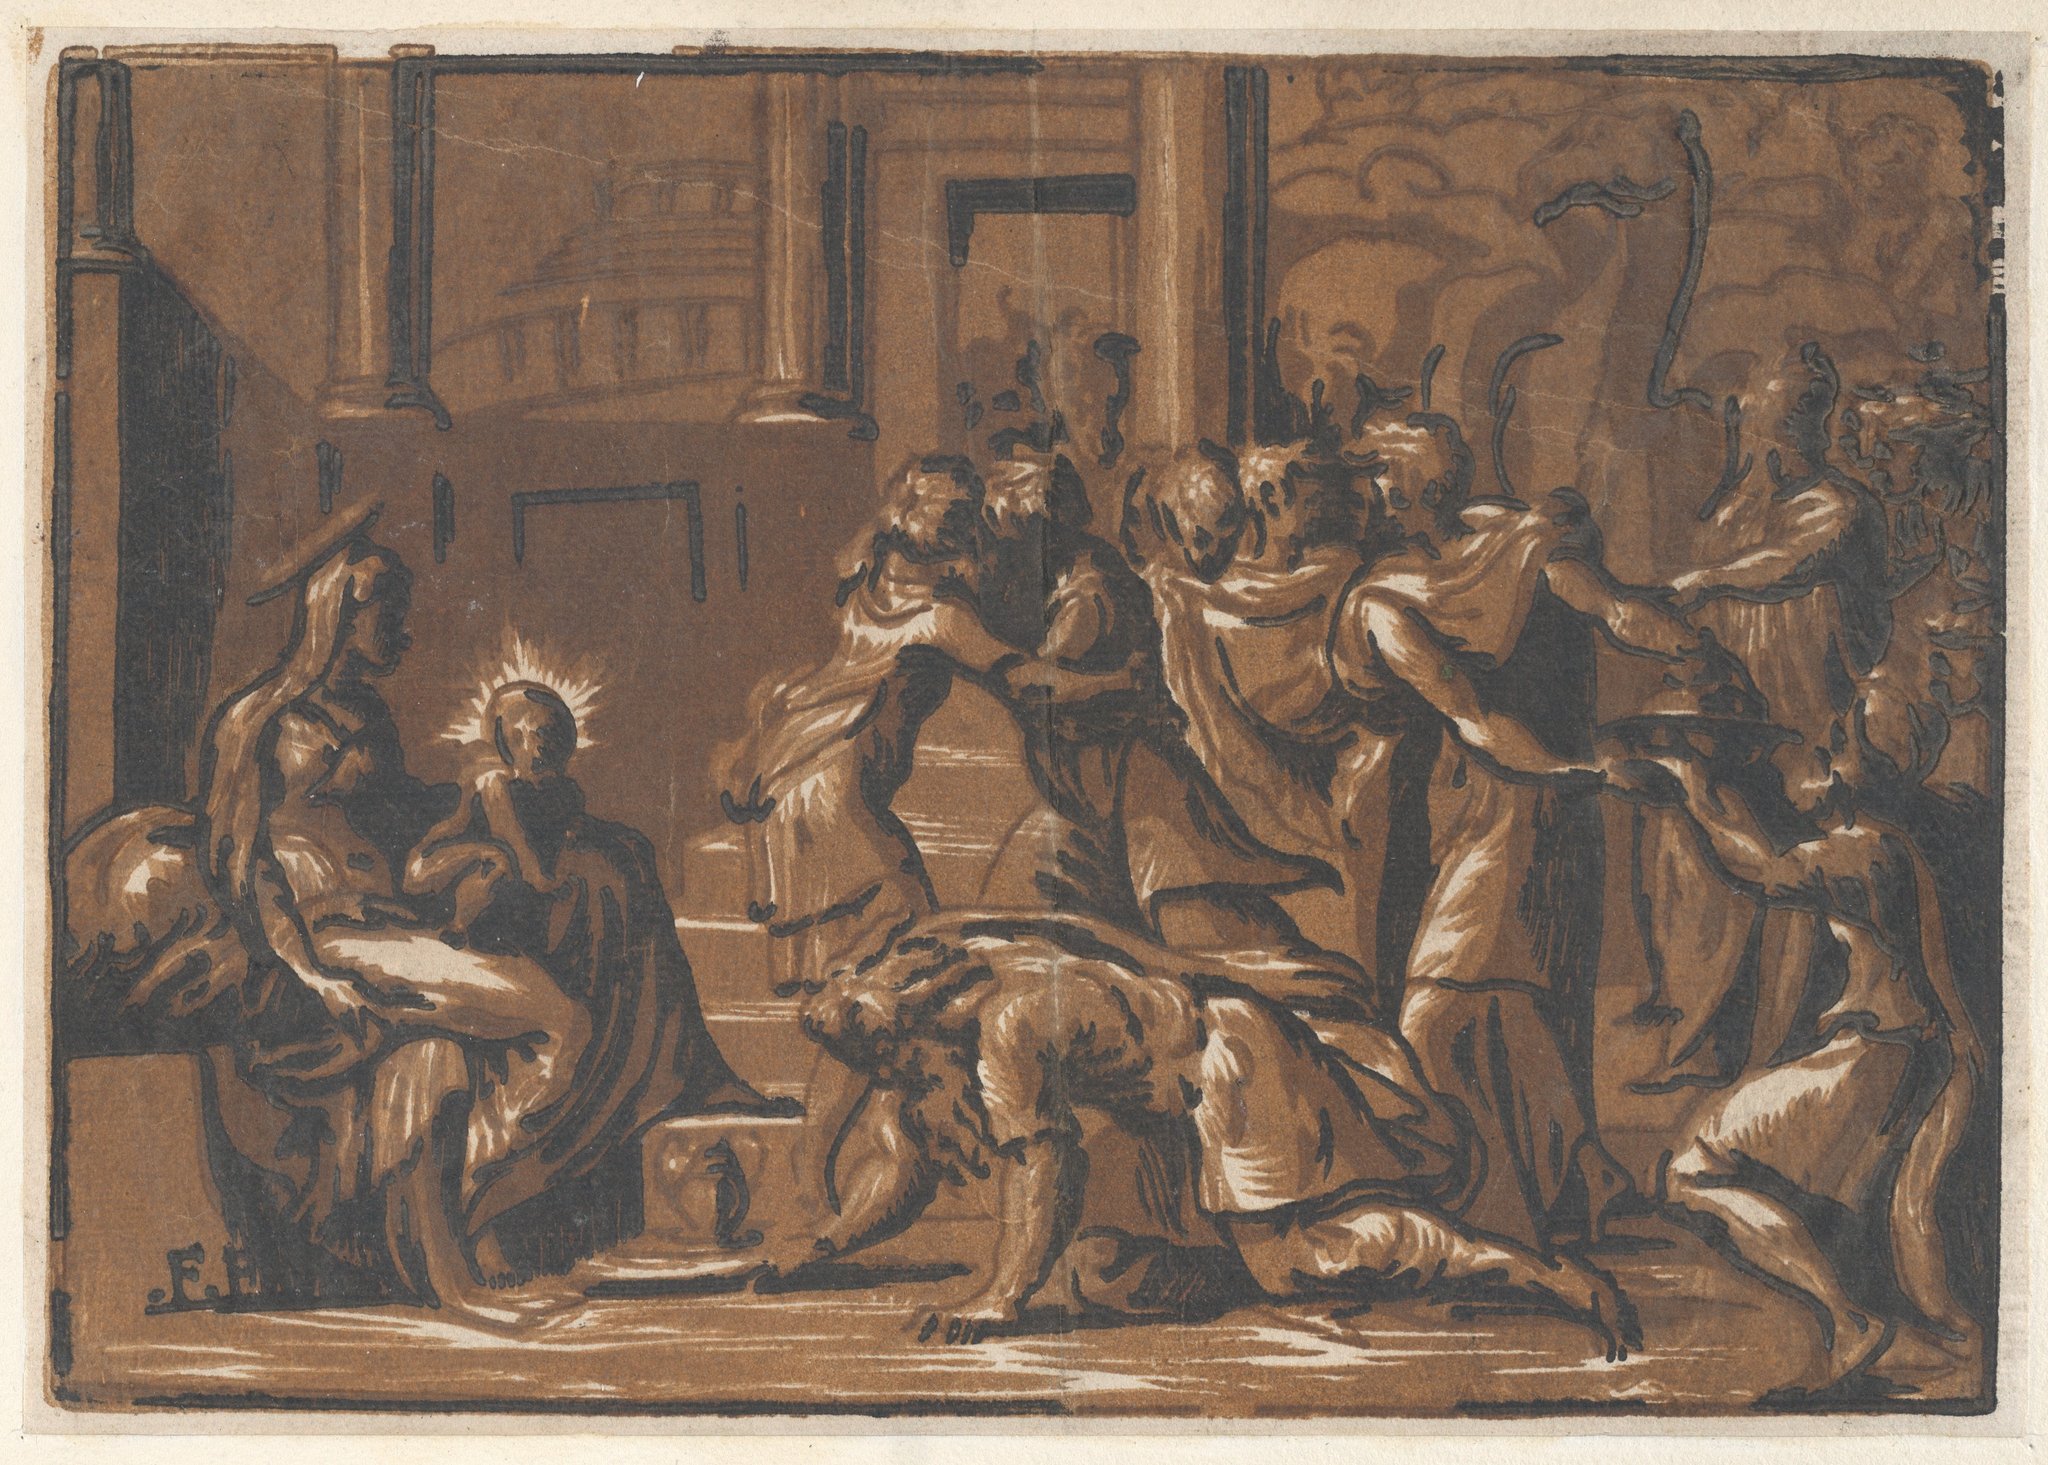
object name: print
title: The Adoration of the Magi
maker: niccolò vicentino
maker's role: artist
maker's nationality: italian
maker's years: 1510-1550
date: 1540-1550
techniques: woodcut